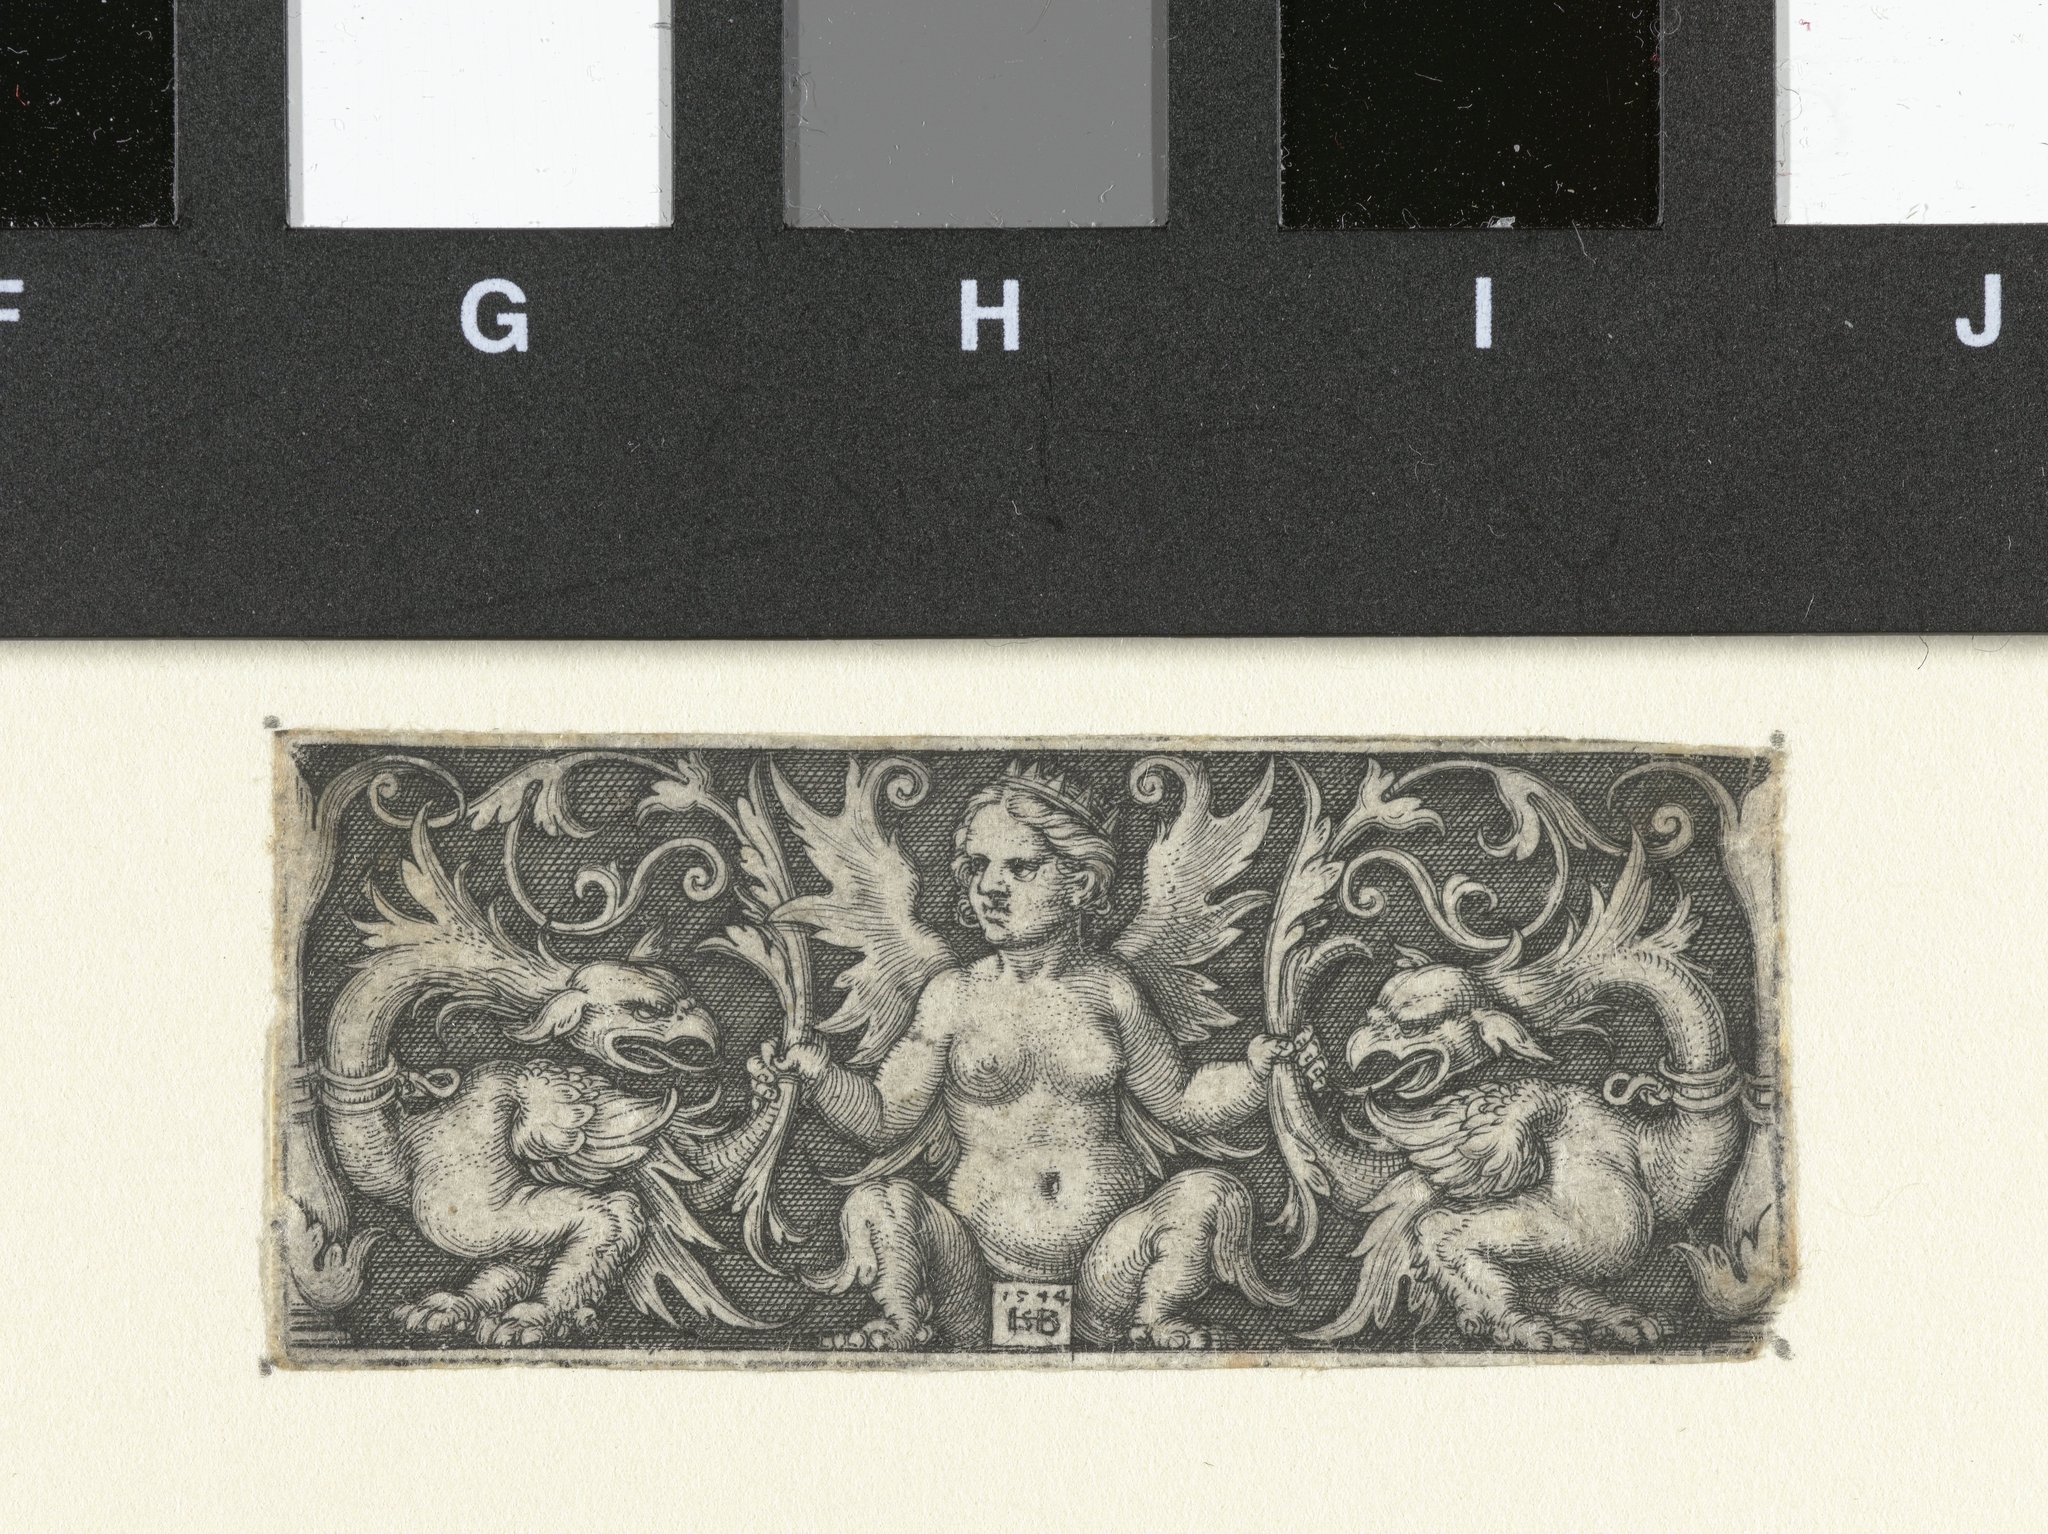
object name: print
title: Friezen met grotesken, putti en bladranken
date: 1510-1544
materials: paper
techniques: engraving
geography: germany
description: Fries met gehurkte vrouwelijke sater met vleugels tussen twee draakjes. Gearceerde achtergrond. 1 blad van 4 bladen.